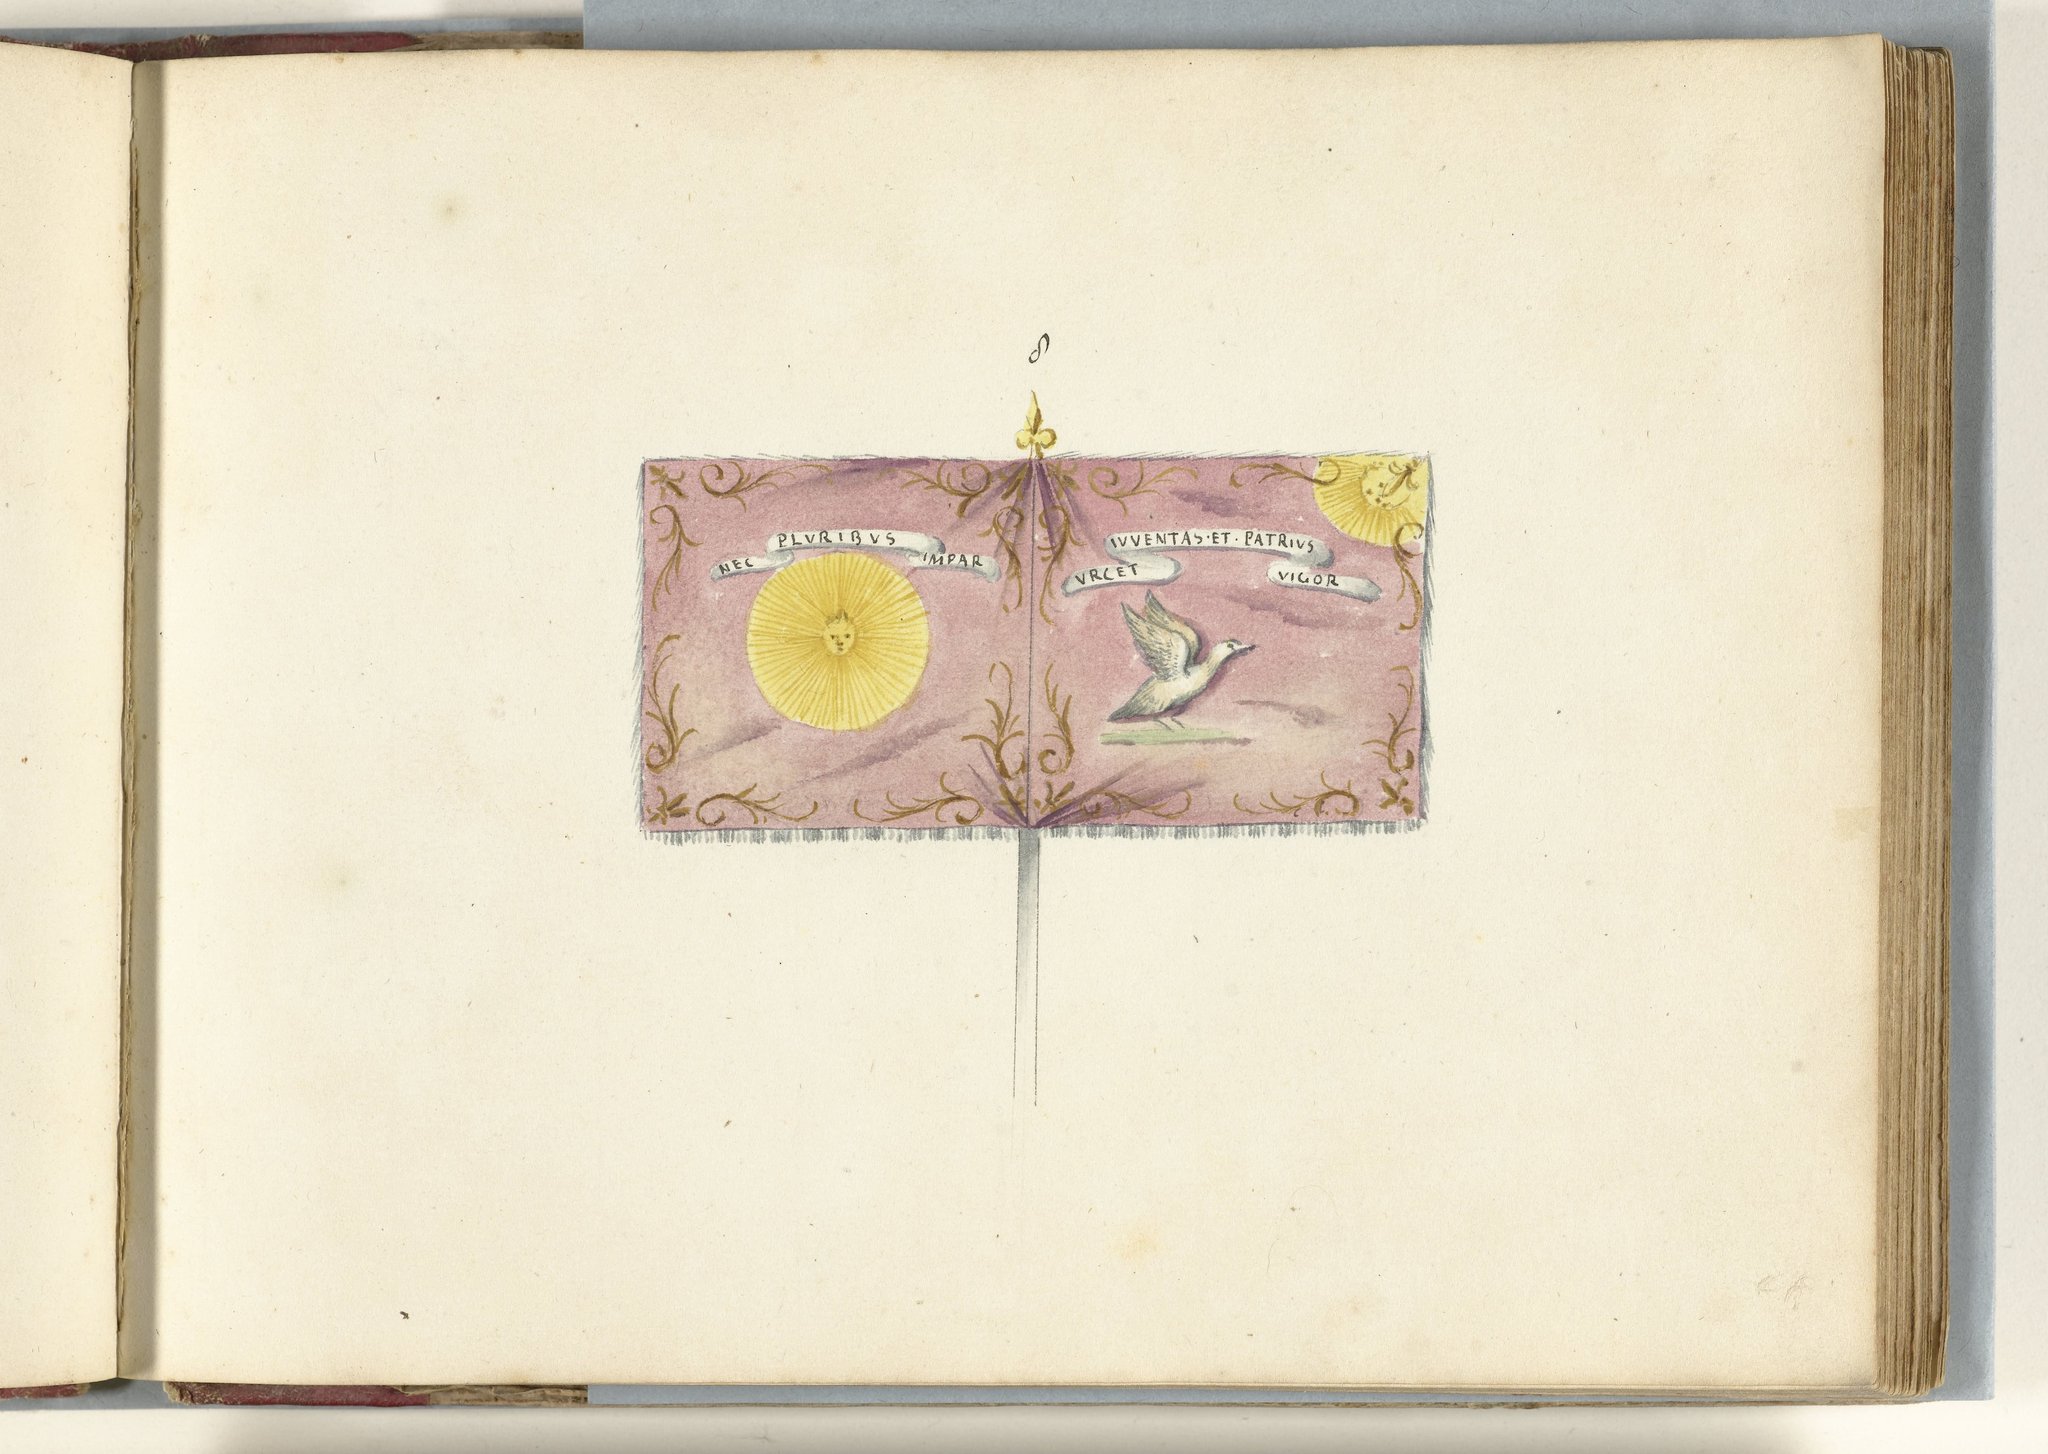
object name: drawing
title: Frans standaard, veroverd in de slag bij Oudenaarde, 1708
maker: Anonymous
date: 1713-1720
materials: paper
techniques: drawing, writing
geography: northern netherlands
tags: (military) flags and standards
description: Een Frans standaard, veroverd bij de slag bij Oudenaarde in 1708. In het boek met tekeningen van Franse vaandels, standaarden en pauken, veroverd tijdens de Spaanse Successieoorlog (1701-1713).